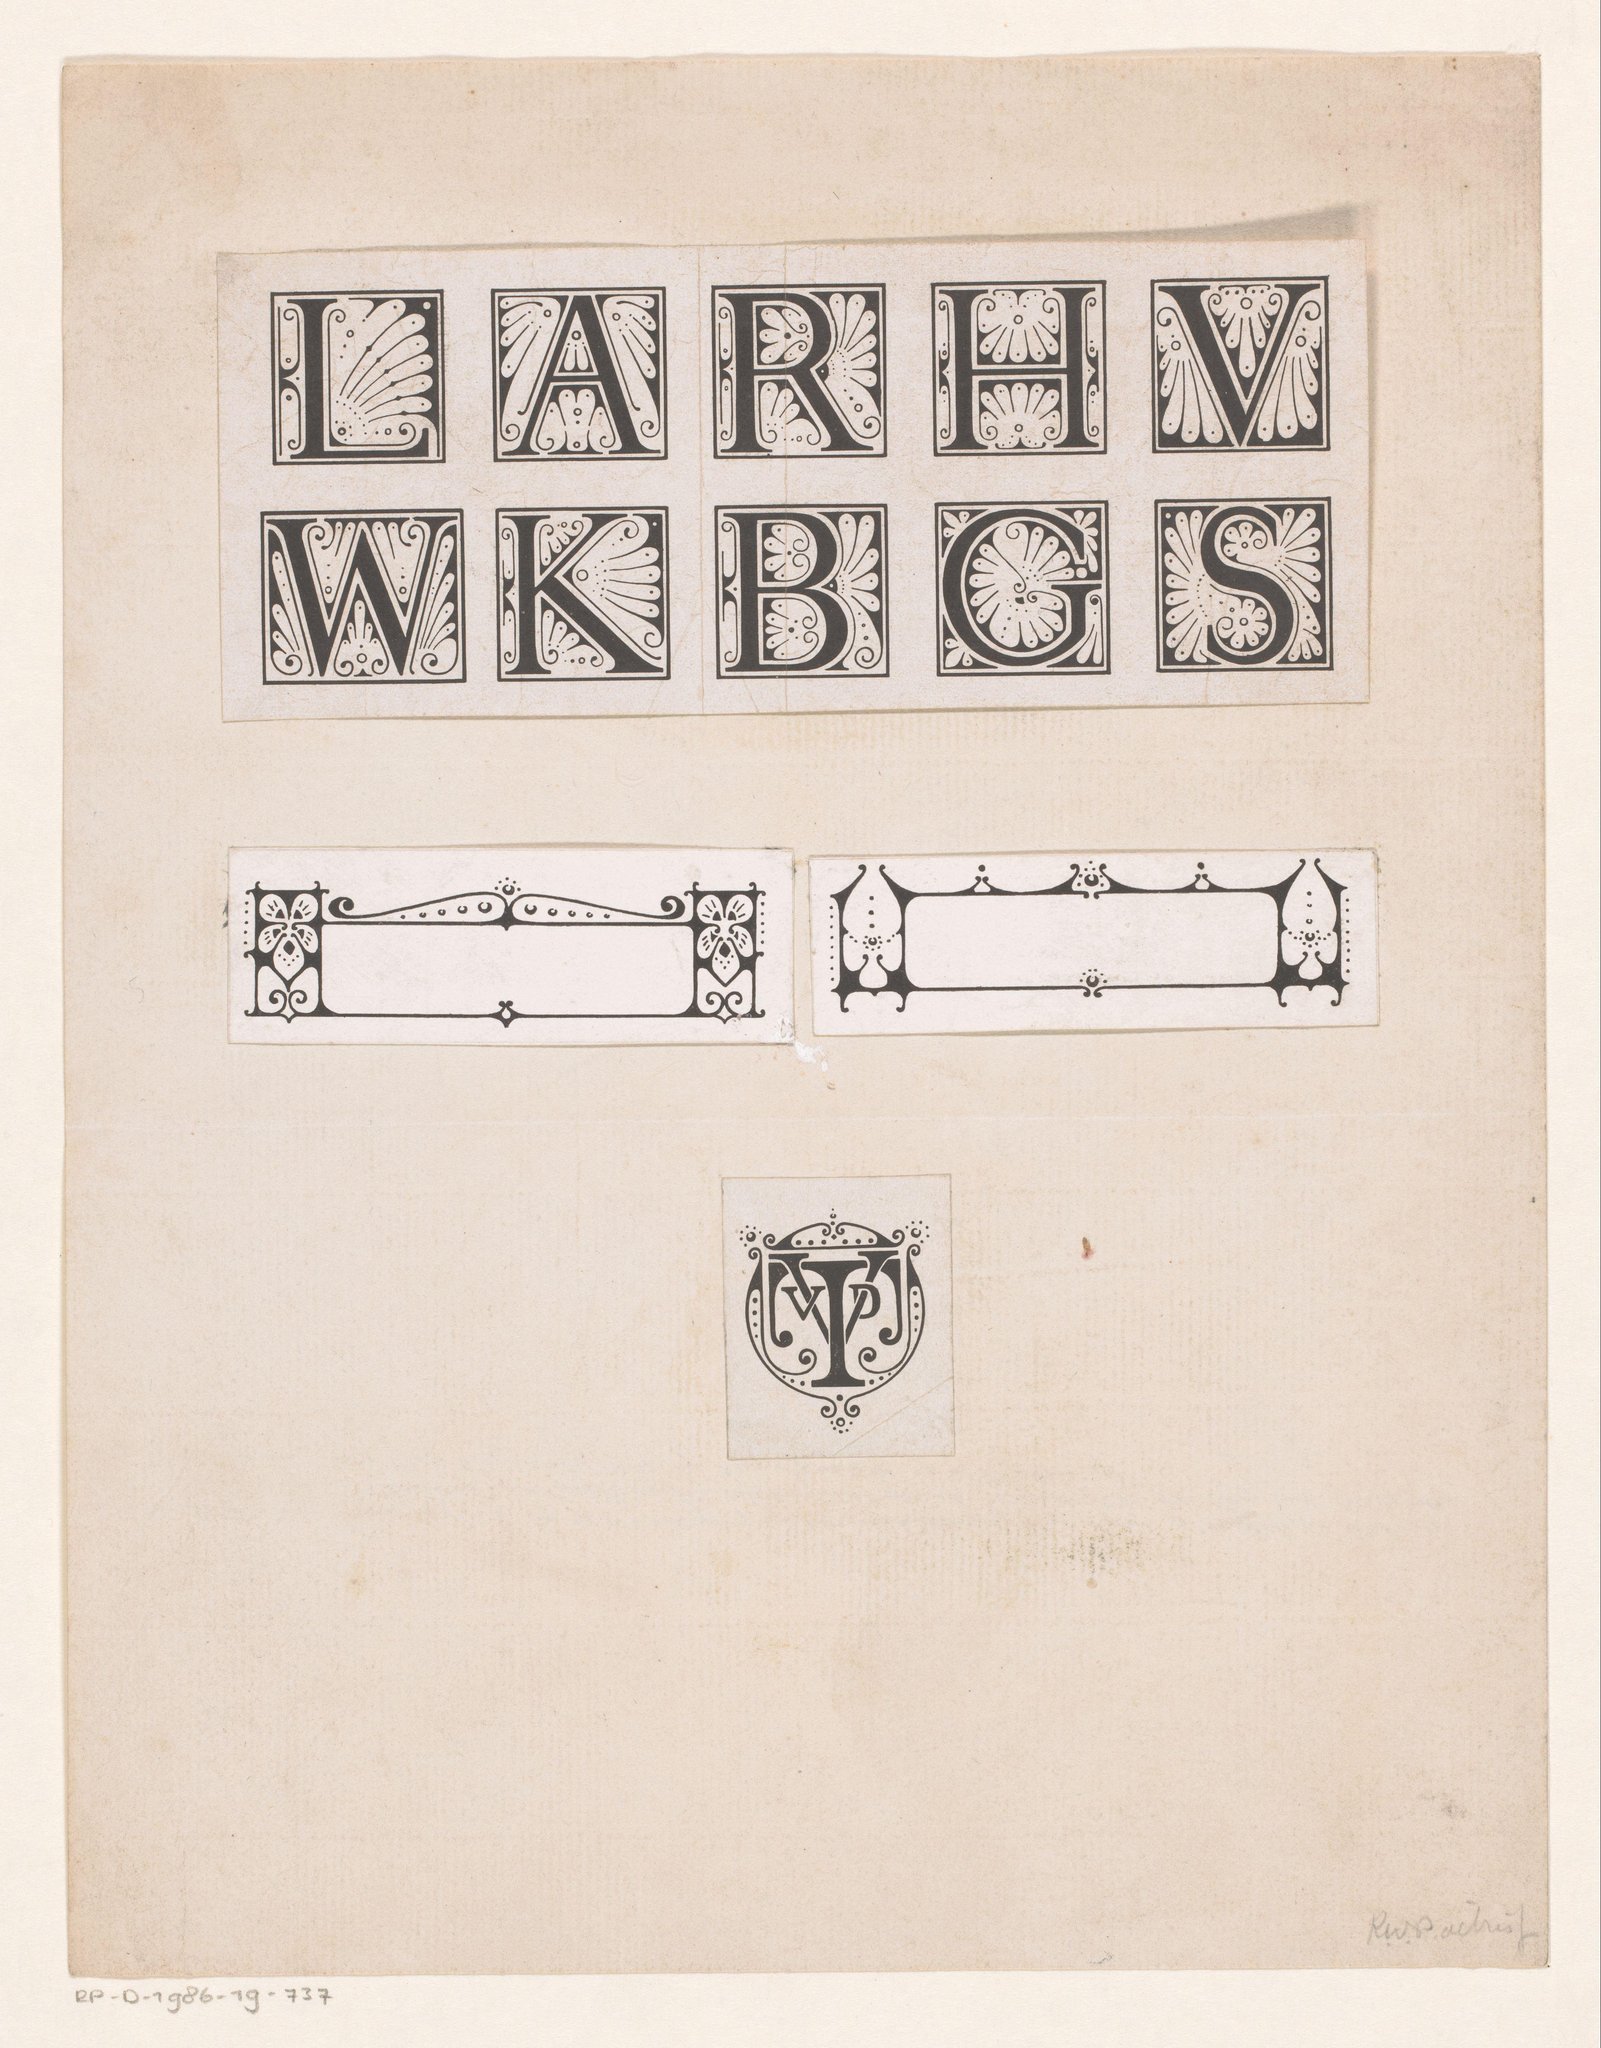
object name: photomechanical print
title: Initialen L, A, R, H, V, W, K, B, G, S, twee tekstkaders en een monogram van de Vakschool voor de Typografie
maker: reinier willem petrus de vries (1874-1953)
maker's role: draughtsman, print maker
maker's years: 1874-1953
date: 1904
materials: paper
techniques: printing block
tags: initial, flowers ~ ornament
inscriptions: signature: ‘R.W.P. Jr.’, annotation: ‘RWP archief’, collector's mark: ‘R:MVS.’, annotation: ‘1194 en 1195 [...] geheel is uitgeleverd’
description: De initialen zijn gebruikt voor: Veth, Jan. Jozef Israëls en zijn kunst. Arnhem en Nijmegen: Gebroeders E&M Cohen, 1904.